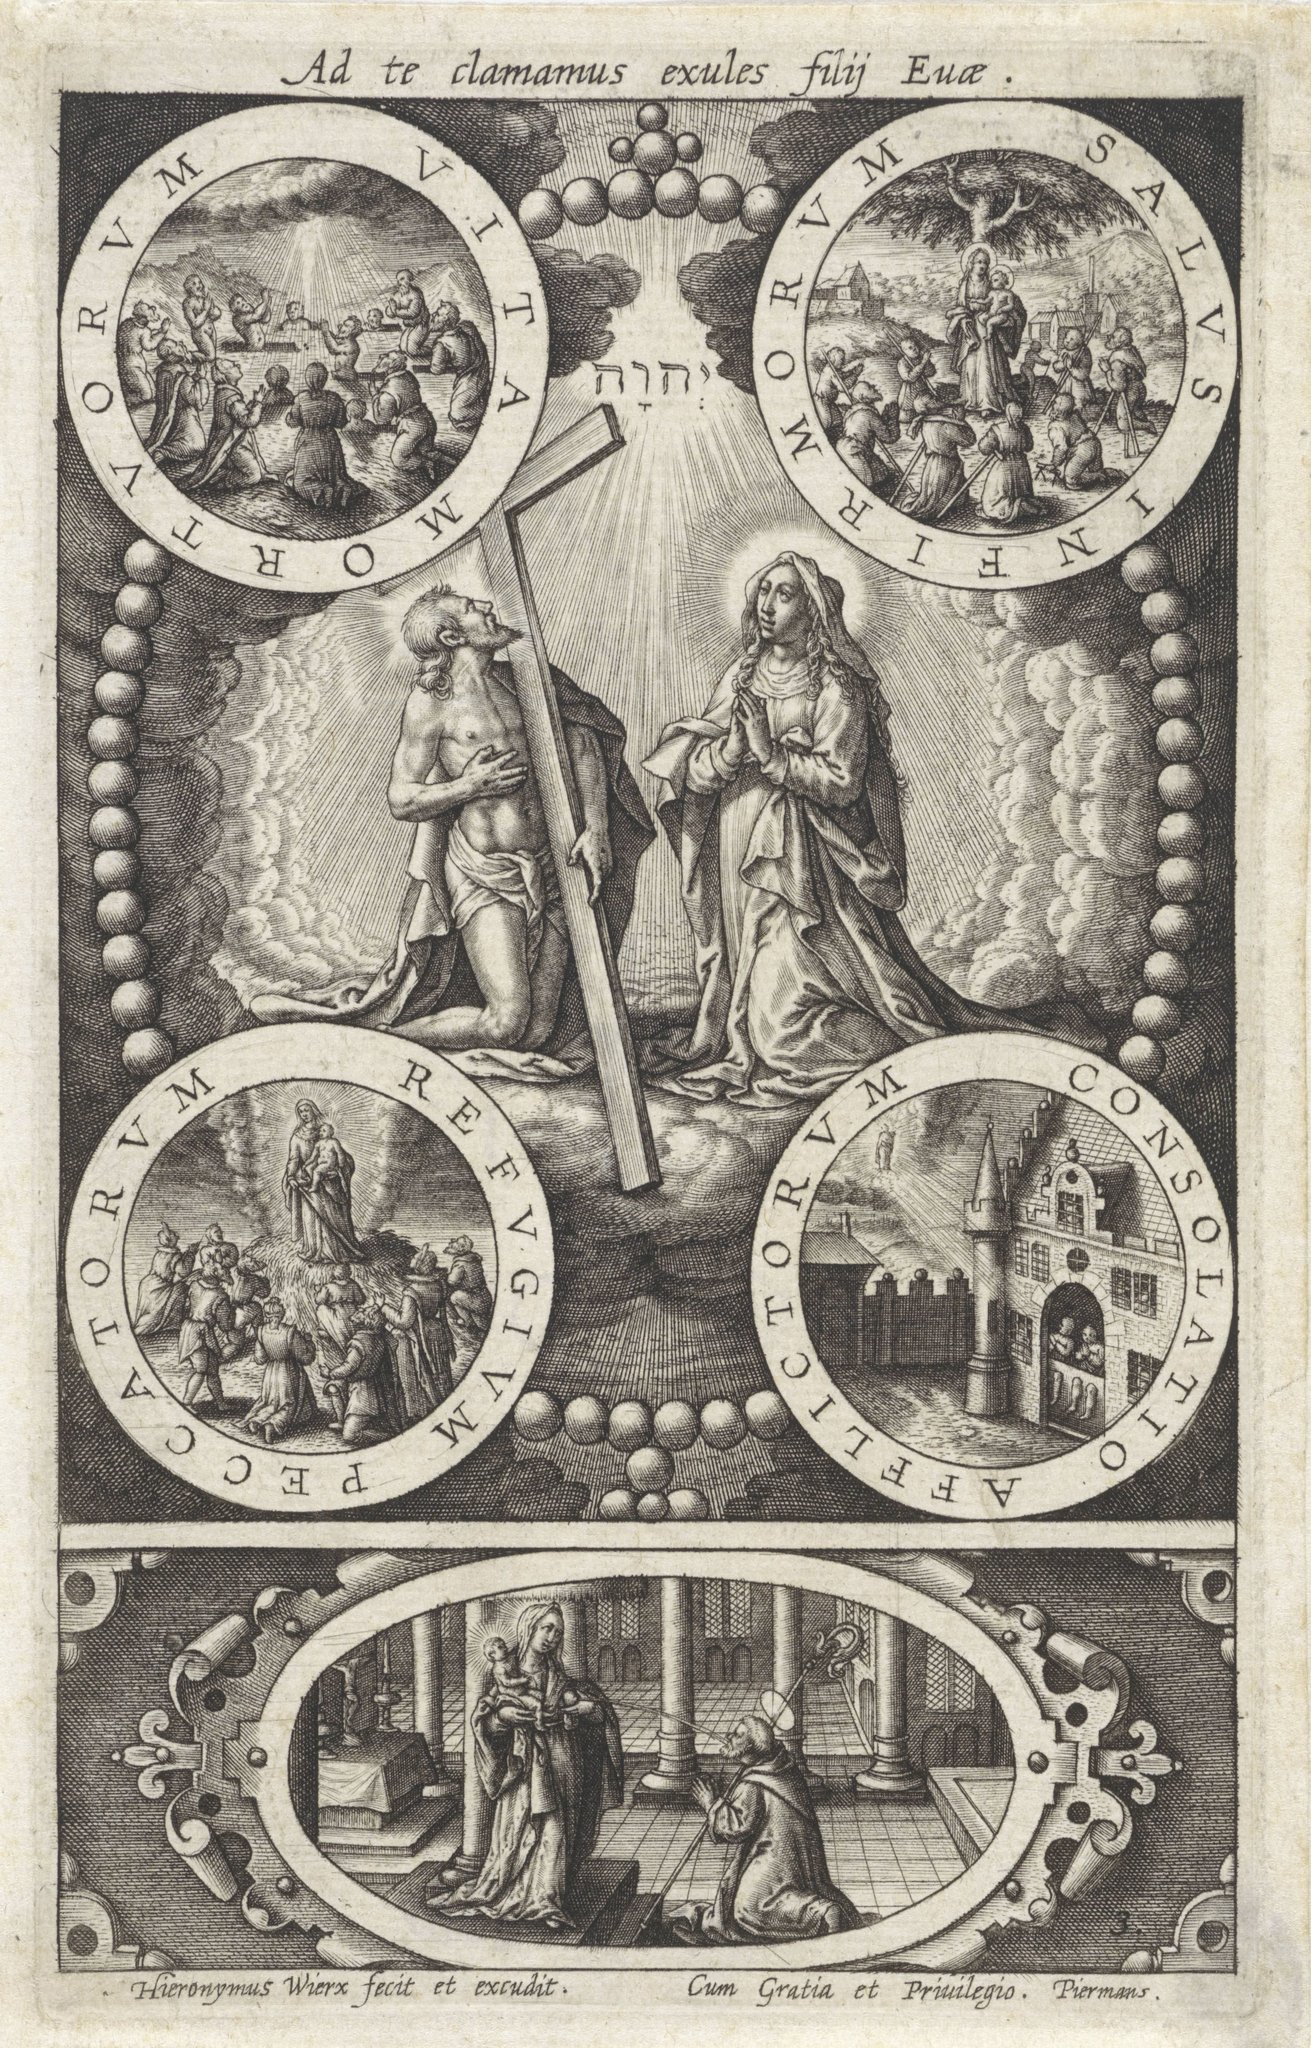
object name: print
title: Maria als beschermheilige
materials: paper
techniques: engraving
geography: antwerp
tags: st. bernard of clairvaux kneels before the virgin mary who presses her breast from which milk spouts, wetting the lips of bernard ('lactatio'), mother of mercy, 'mater misericordiae', 'schutzmantelmadonna', 'schutzmantelmaria', tetragram (in roman or hebrew script) ~ symbol of god the father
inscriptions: collector's mark: Lugt 2228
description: De geknielde Maria en Christus kijken op naar het tetragram dat aan de hemel staat. De voorstelling is gevat in een omlijsting van kralen. In elke hoek een medaillon met scènes van respectievelijk de zielen, de zieken, de zondaars en de gevangen die bidden tot Maria. In de cartouche onderaan knielt de H. Bernardus van Clairvaux voor Maria. Melk spuit uit haar borst op de lippen van de heilige (Lactatio Bernardi). De prent heeft een bovenschrift in het Latijn.